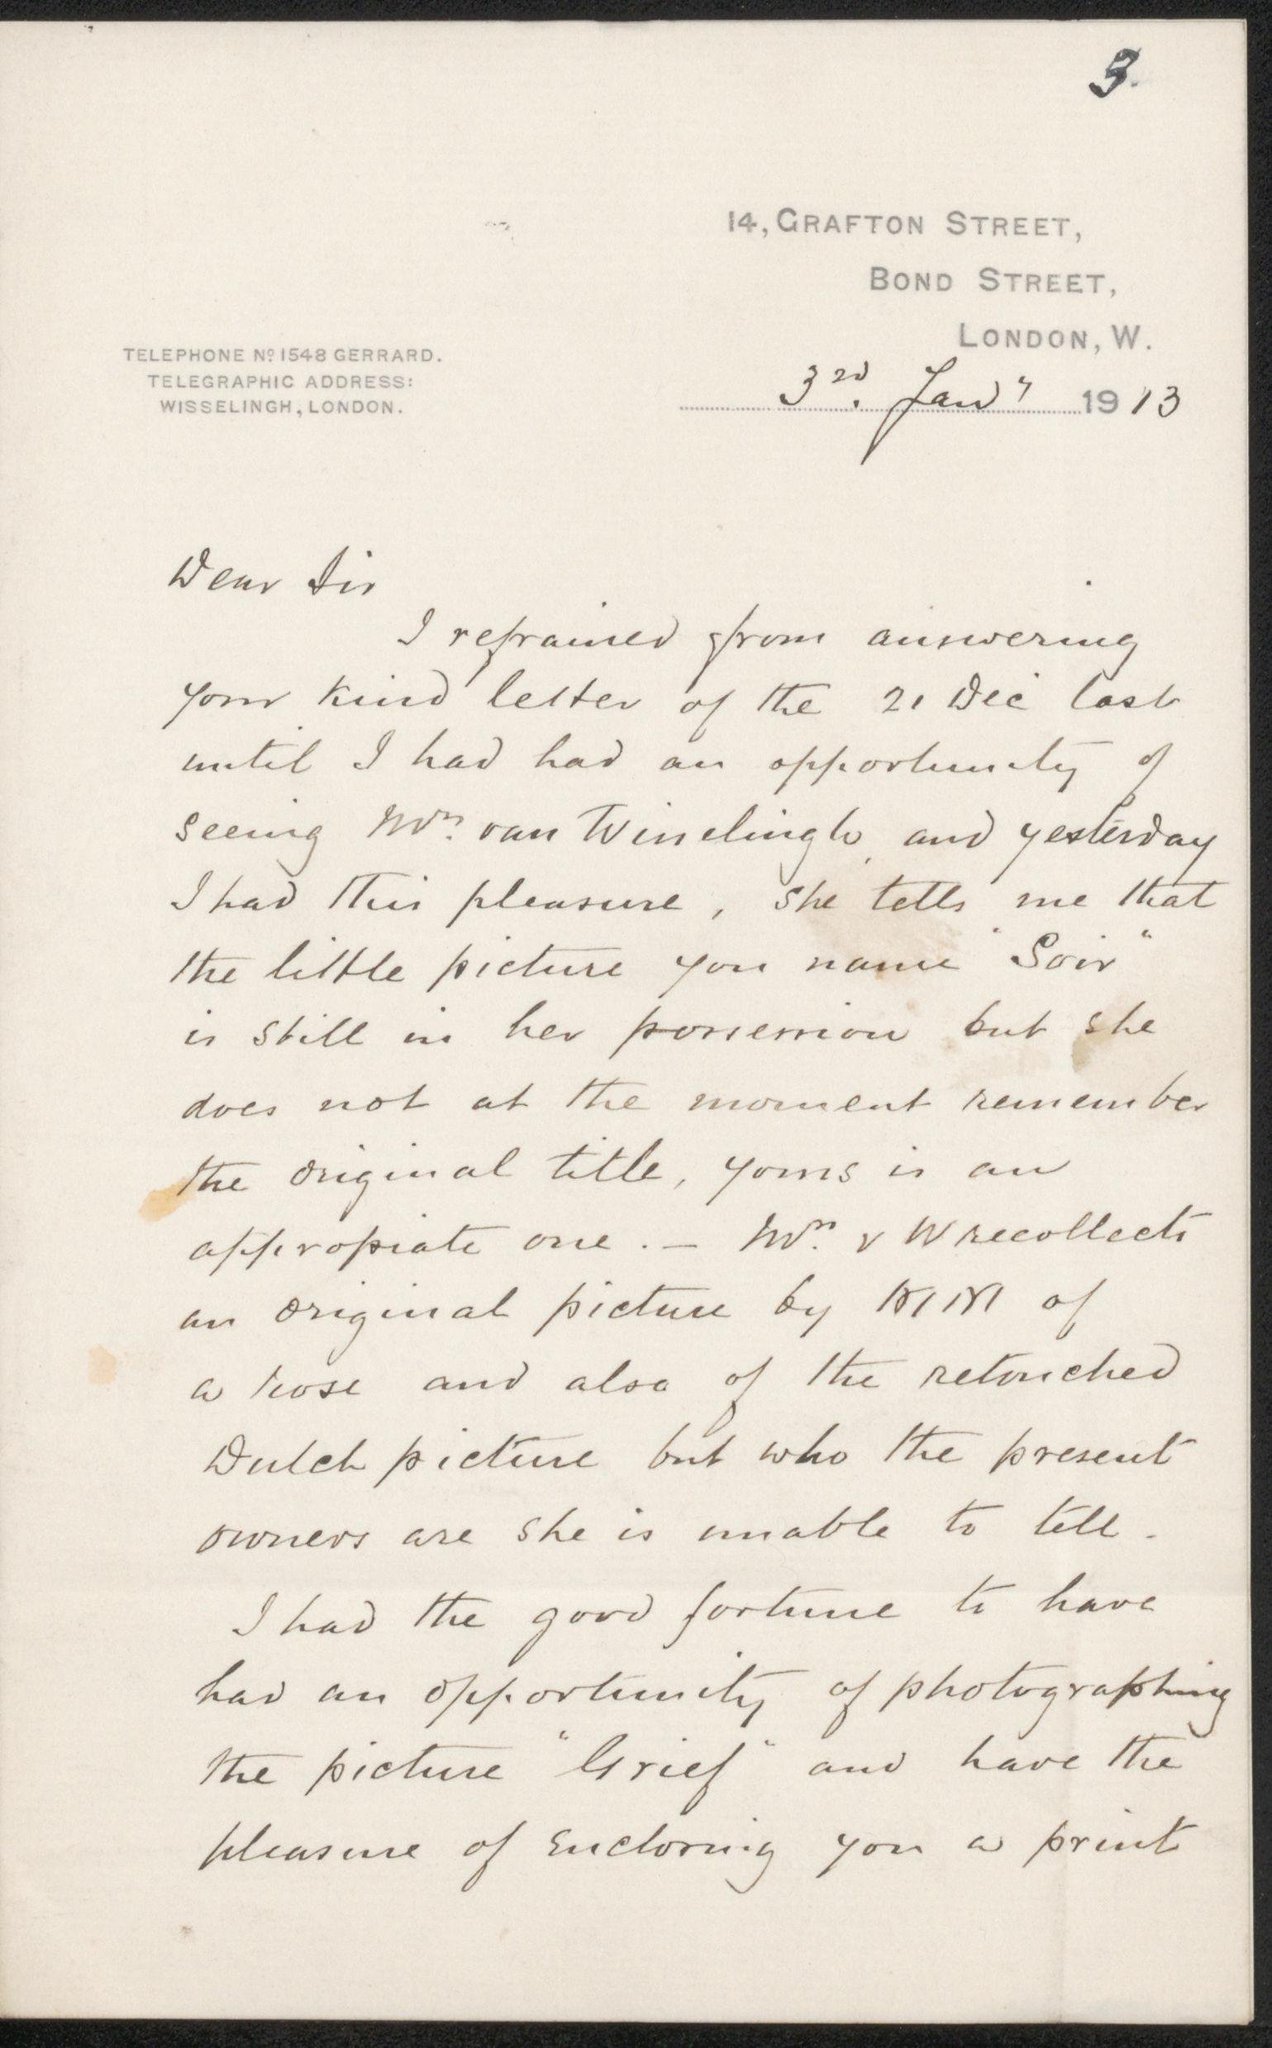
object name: letter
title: Brief aan Pieter Haverkorn van Rijsewijk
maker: george r. reid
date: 1913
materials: ink, paper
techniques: pen, printing, writing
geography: london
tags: the hague, london, painter, print maker, draughtsman, matthijs maris, pieter haverkorn van rijsewijk, isabella murray mowat angus, photography, cinematography, painting (including book-illumination, miniature-painting)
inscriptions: watermark